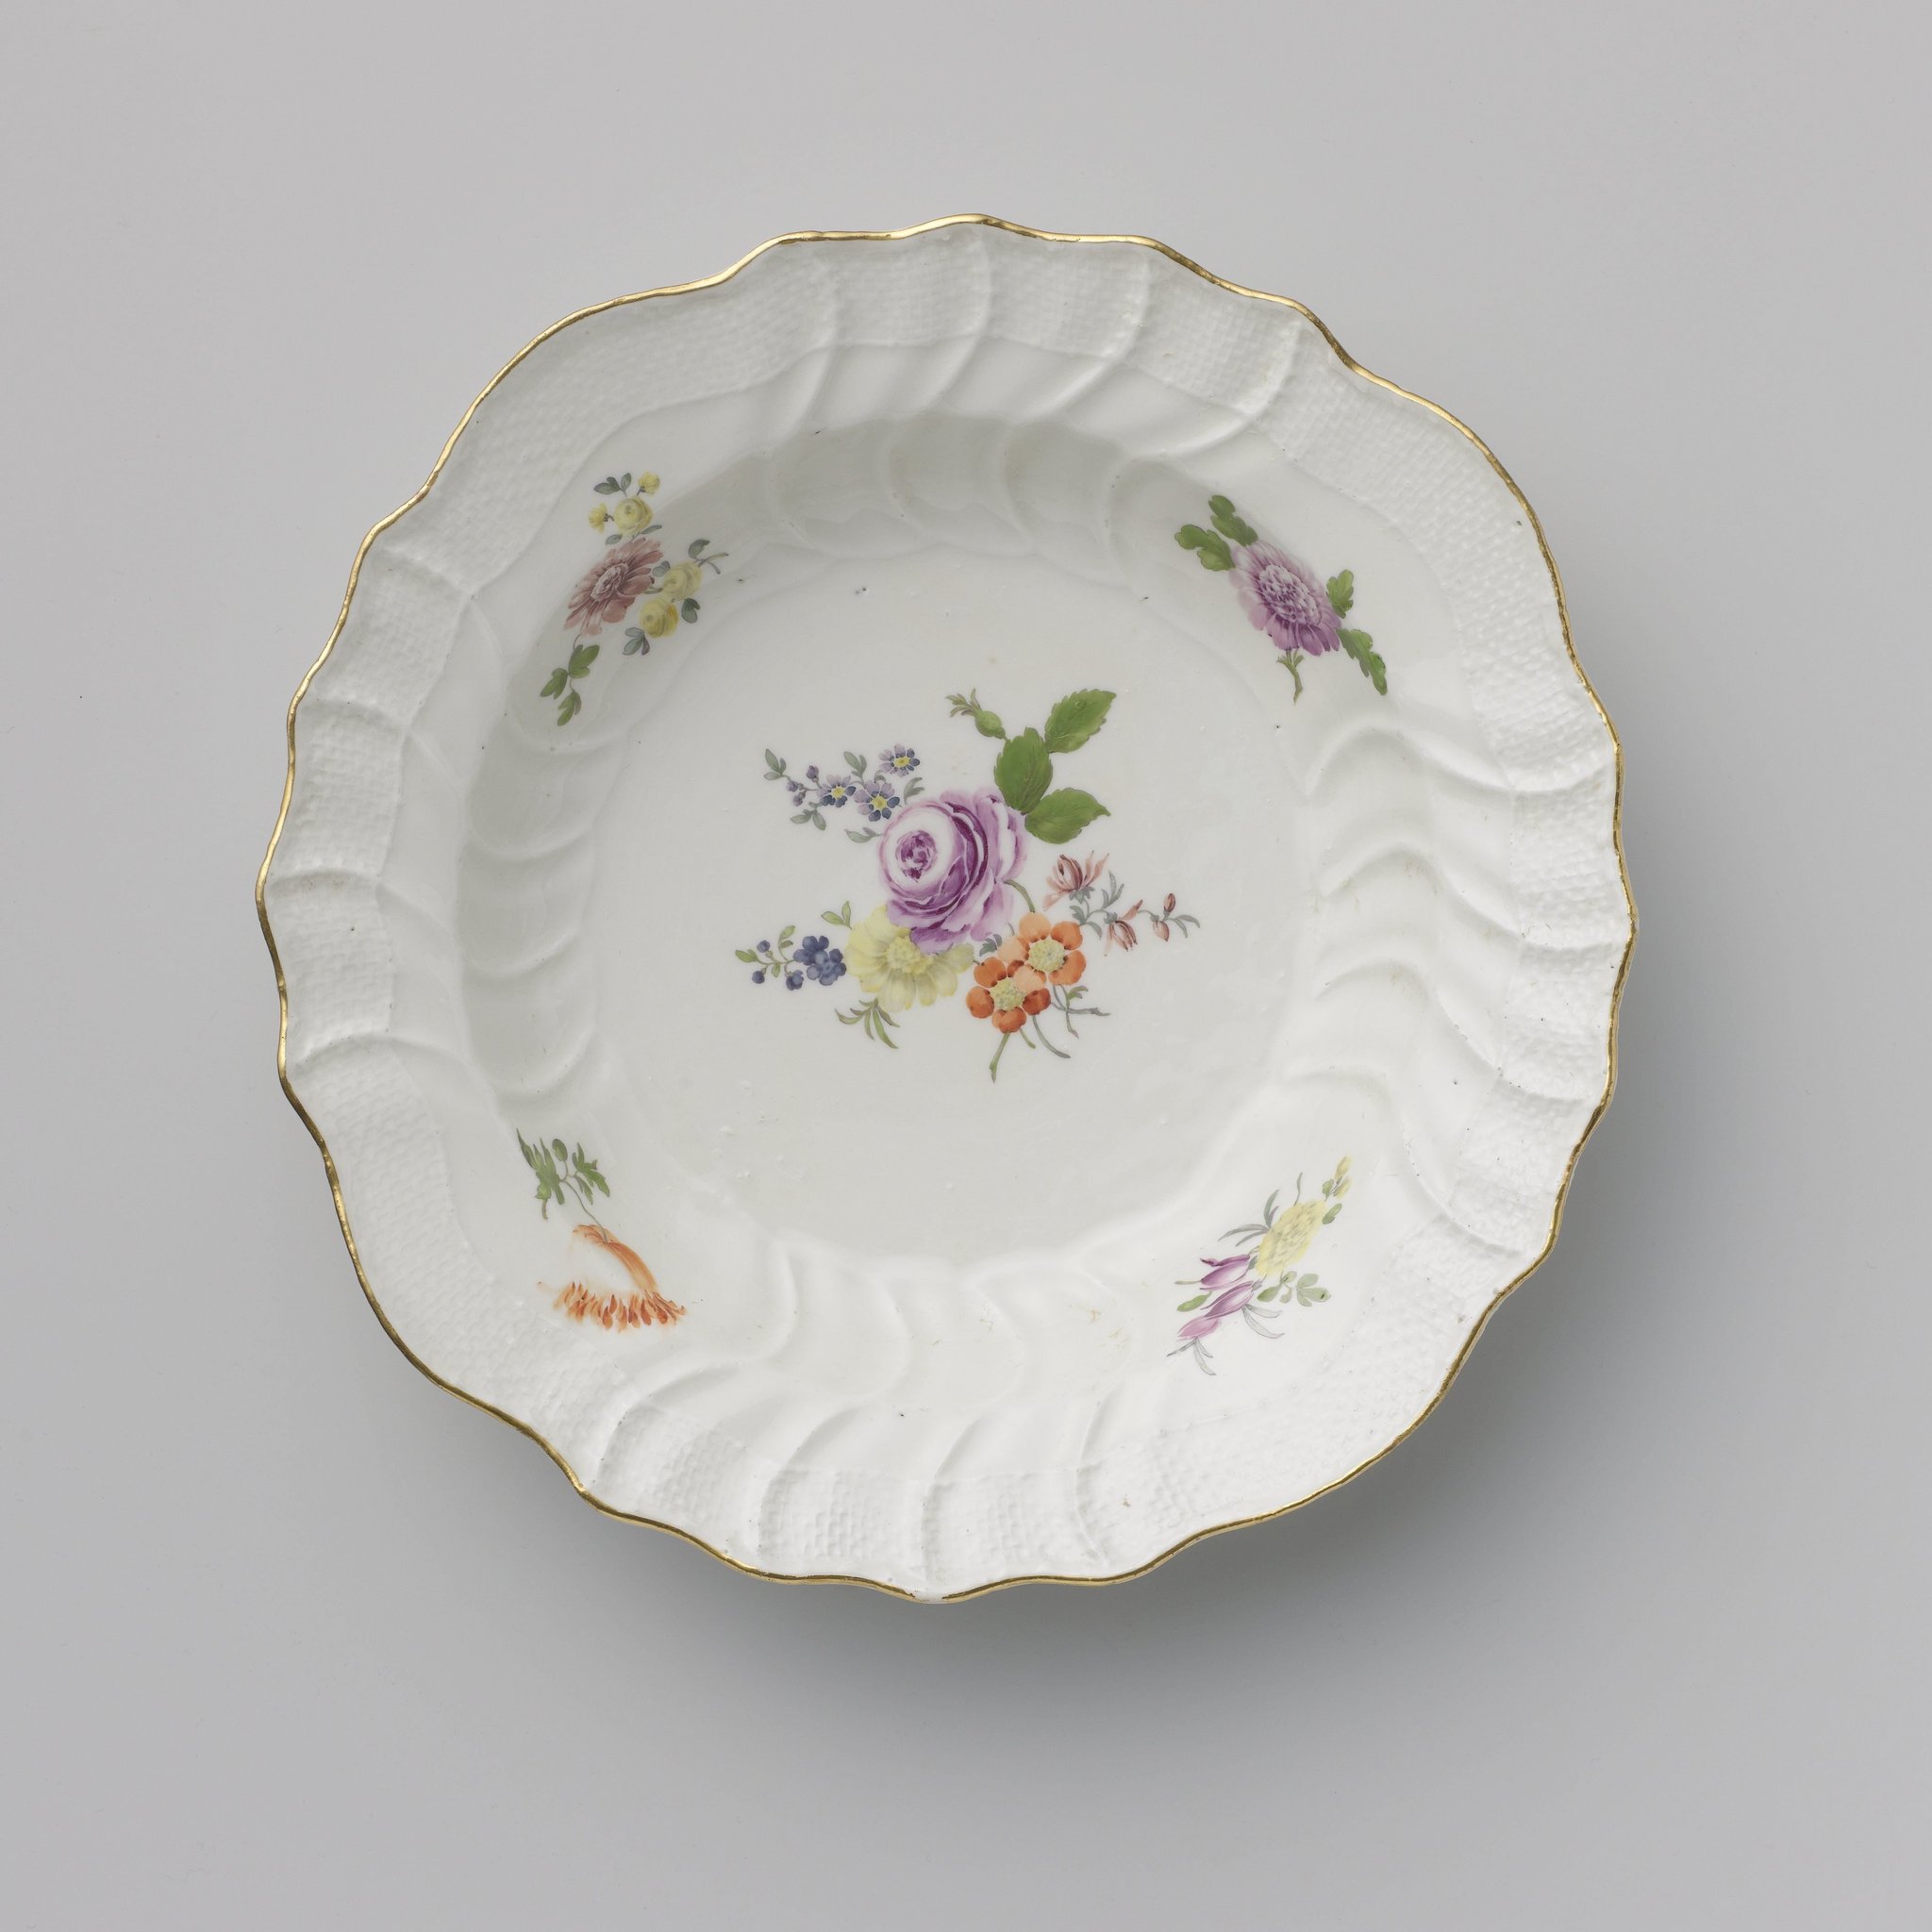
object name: plate dish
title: Bord, veelkleurig beschilderd met Deutsche Blumen, insekten en vruchten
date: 1750-1760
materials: porcelain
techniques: painted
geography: meissen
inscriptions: factory mark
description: Rond soepbord van beschilderd porselein. Het bord is beschilderd met Deutsche Blumen, insekten en vruchten. De rand is in reliëf versierd met het Neuozier-patroon. Het bord is gemerkt en hoort bij een servies (BK-17474-1 t/m BK-17474-253).